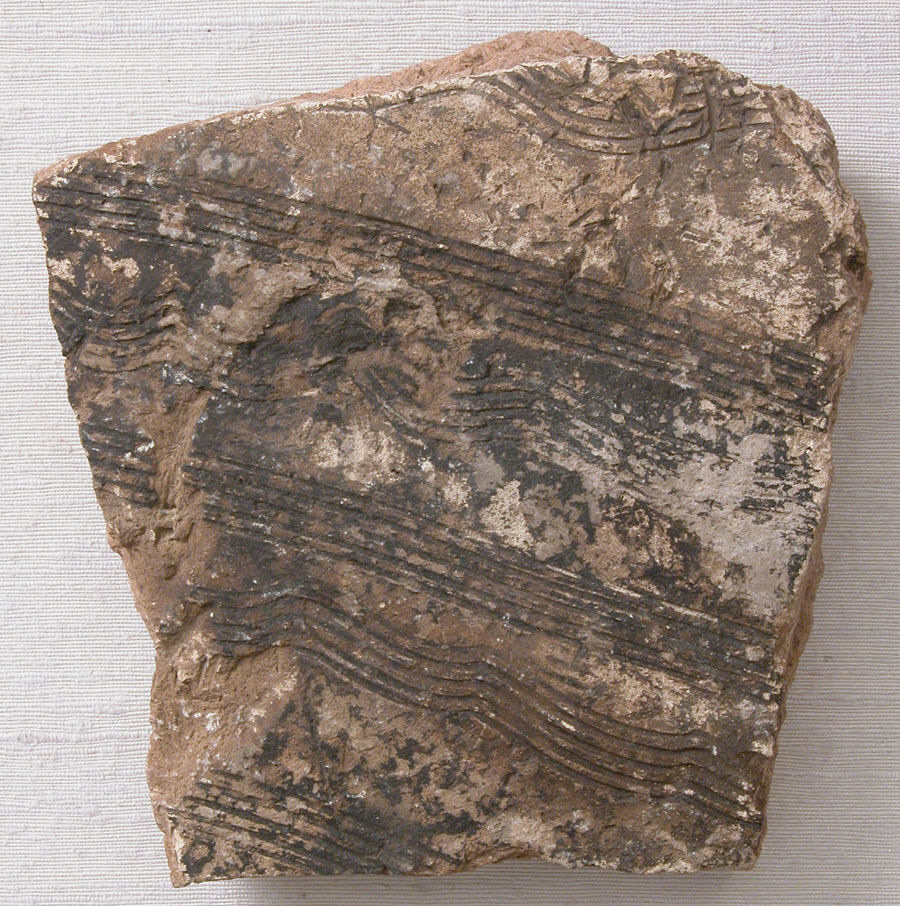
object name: fragment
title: Ceramic Fragment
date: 701-900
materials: earthenware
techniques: incising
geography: iraq